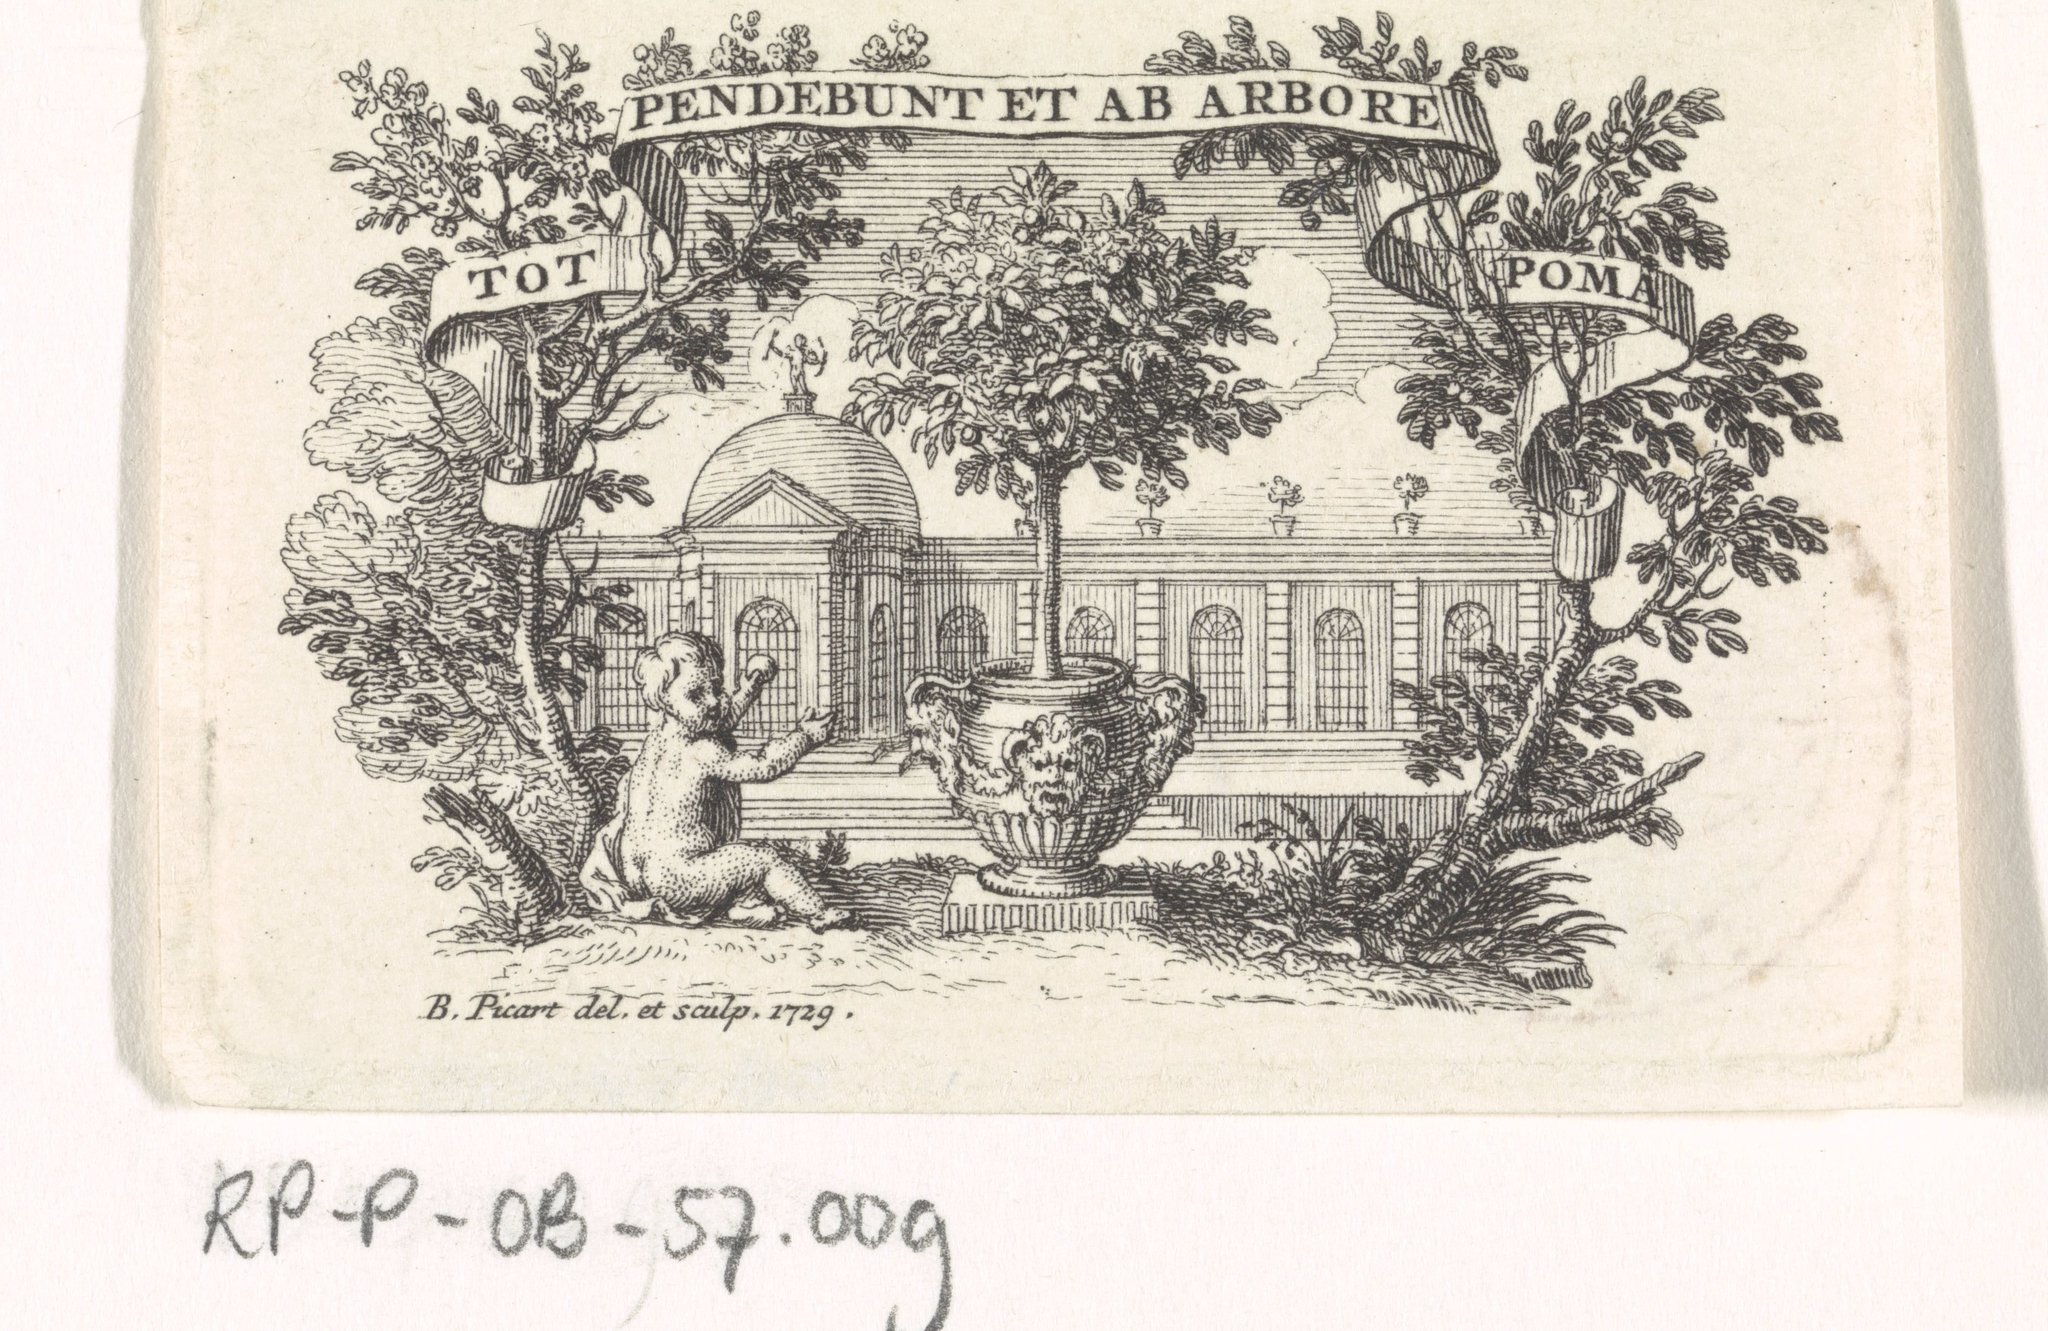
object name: print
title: Putto bij sinaasappelboom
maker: bernard picart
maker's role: draughtsman, print maker, publisher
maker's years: 1673-1733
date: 1729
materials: paper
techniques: engraving, etching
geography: amsterdam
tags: cupids: 'amores', 'amoretti', 'putti', fruits: orange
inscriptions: collector's mark: Lugt 240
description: Een putto wijst met een sinaasappel in de hand op een sinaasappelboom en een paleis. Bovenaan op een banderol het devies: Tot Pendebunt Et Ab Arbore Poma.